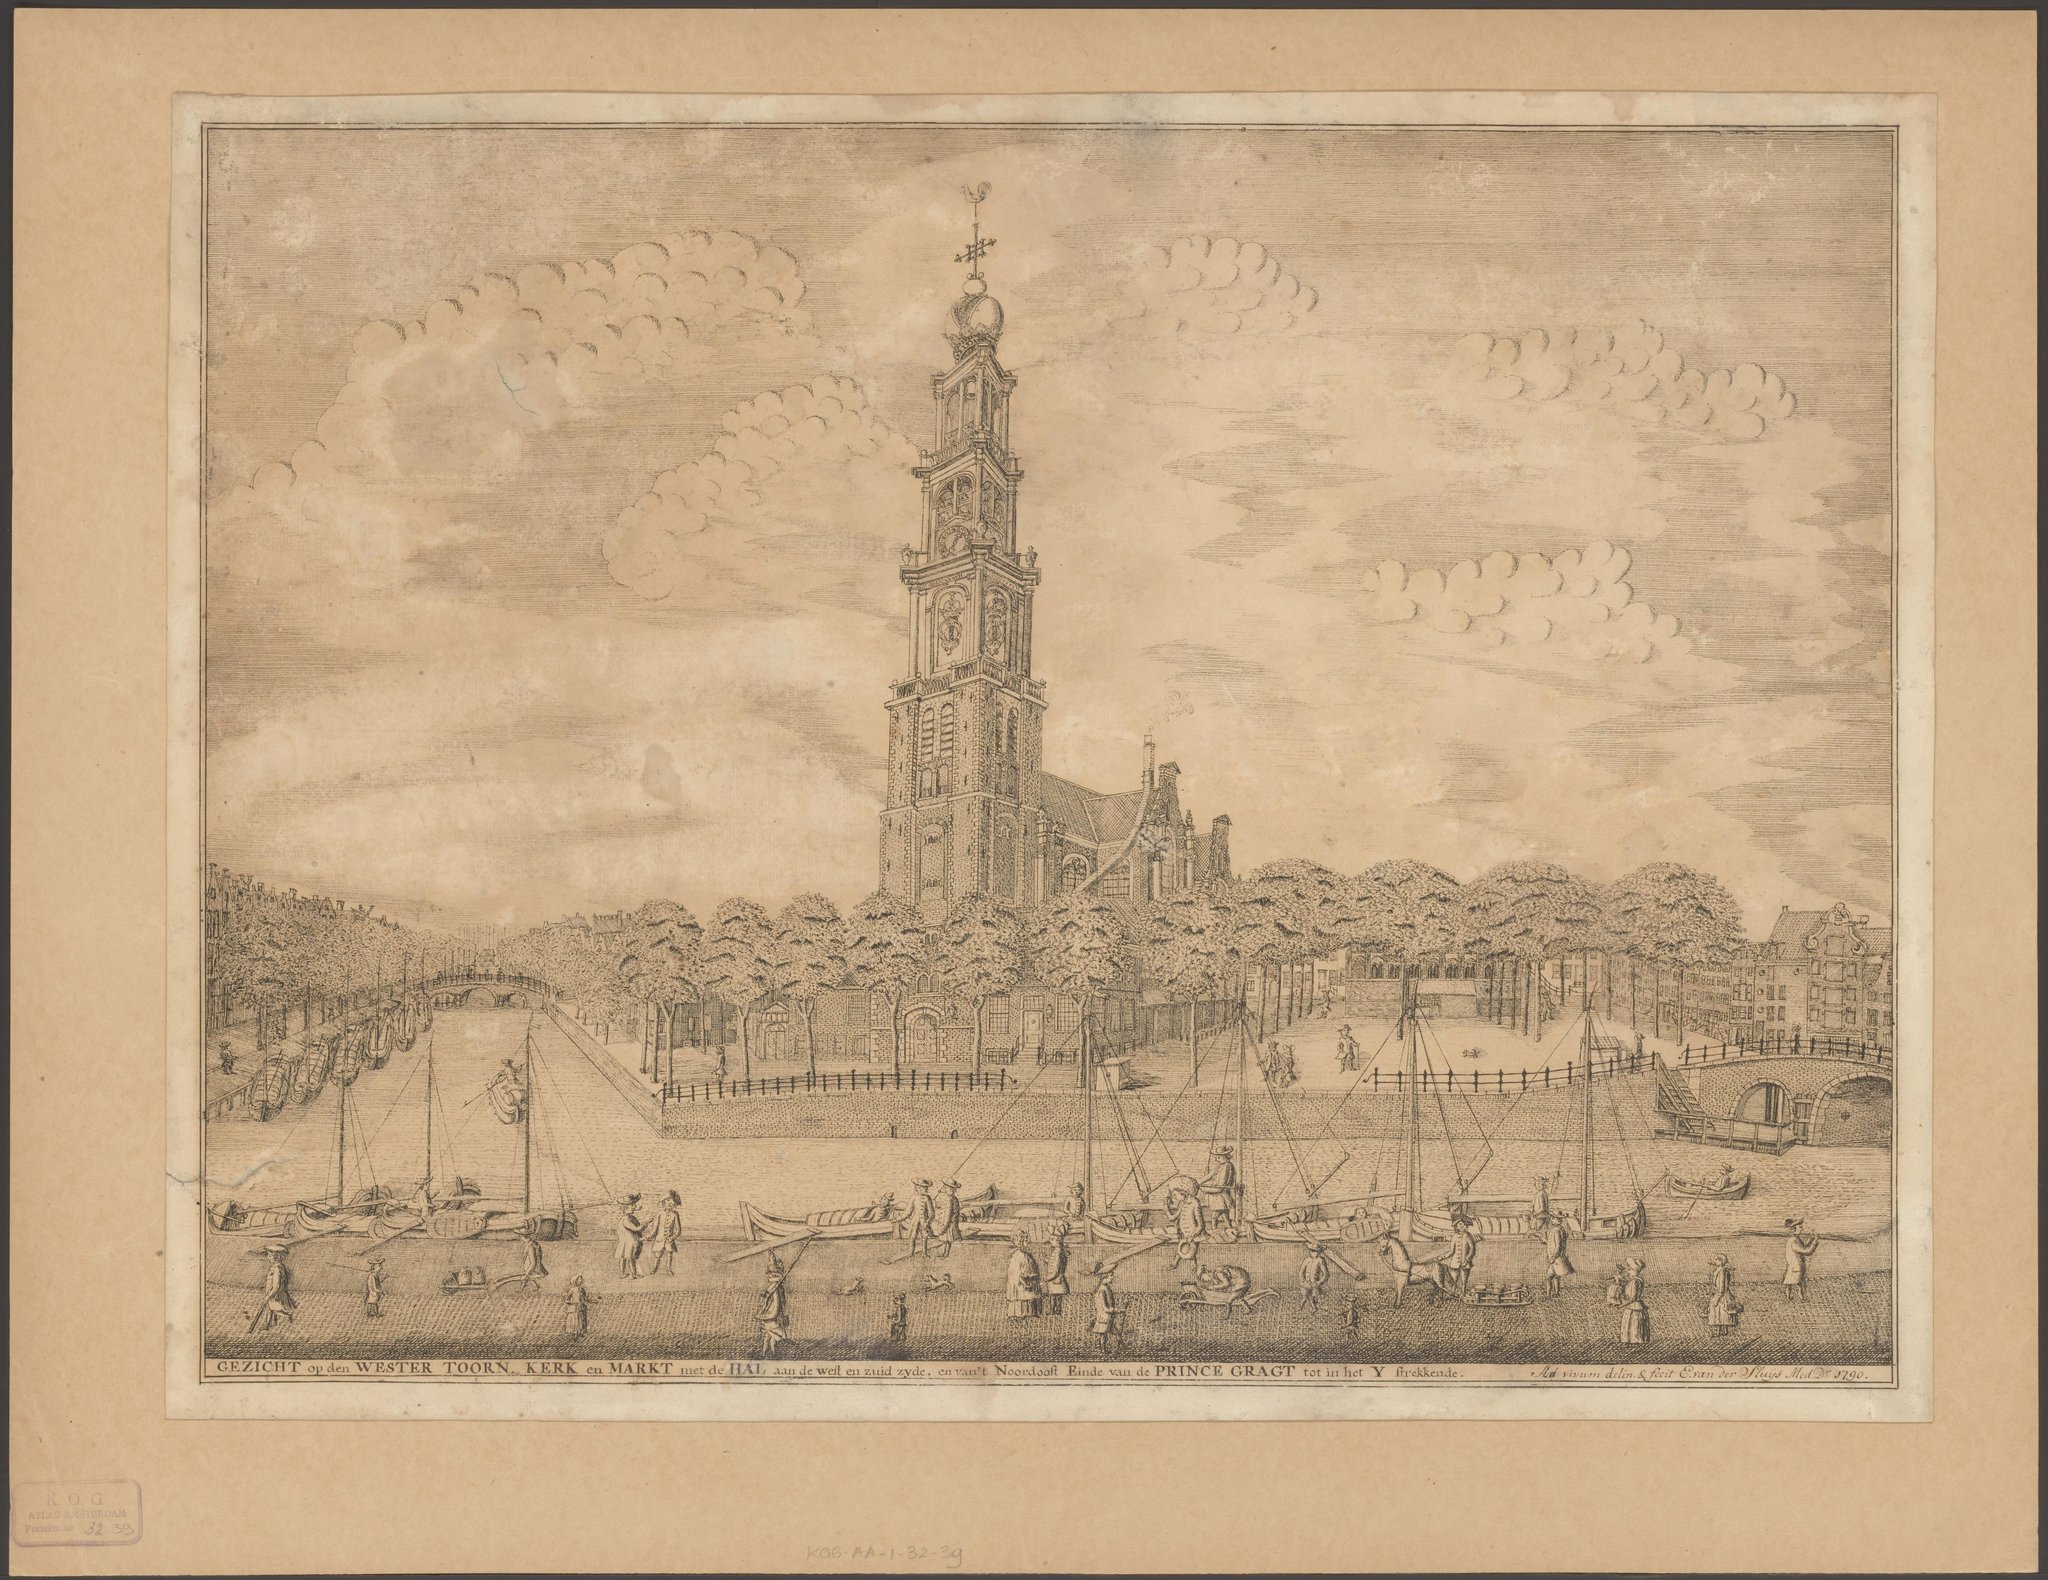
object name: drawing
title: Gezicht op de Westerkerk en Westermarkt, gezien vanaf de Prinsengracht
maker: engelbertus van der sluijs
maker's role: amateurtekenaar, medicus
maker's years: 1705-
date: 1790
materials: ink, paper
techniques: pen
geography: netherlands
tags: bridge in city across river, canal, etc. (+ city(-scape) with figures, staffage), church (exterior), canals, waters (in city), weigh-house, market-hall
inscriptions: collector's mark: ‘32.39’ Lugt 1641b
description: Onderwerpsrubriek binnen de Atlas Amsterdam: Kerkwezen: Hervormde Gemeente: Westerkerk.